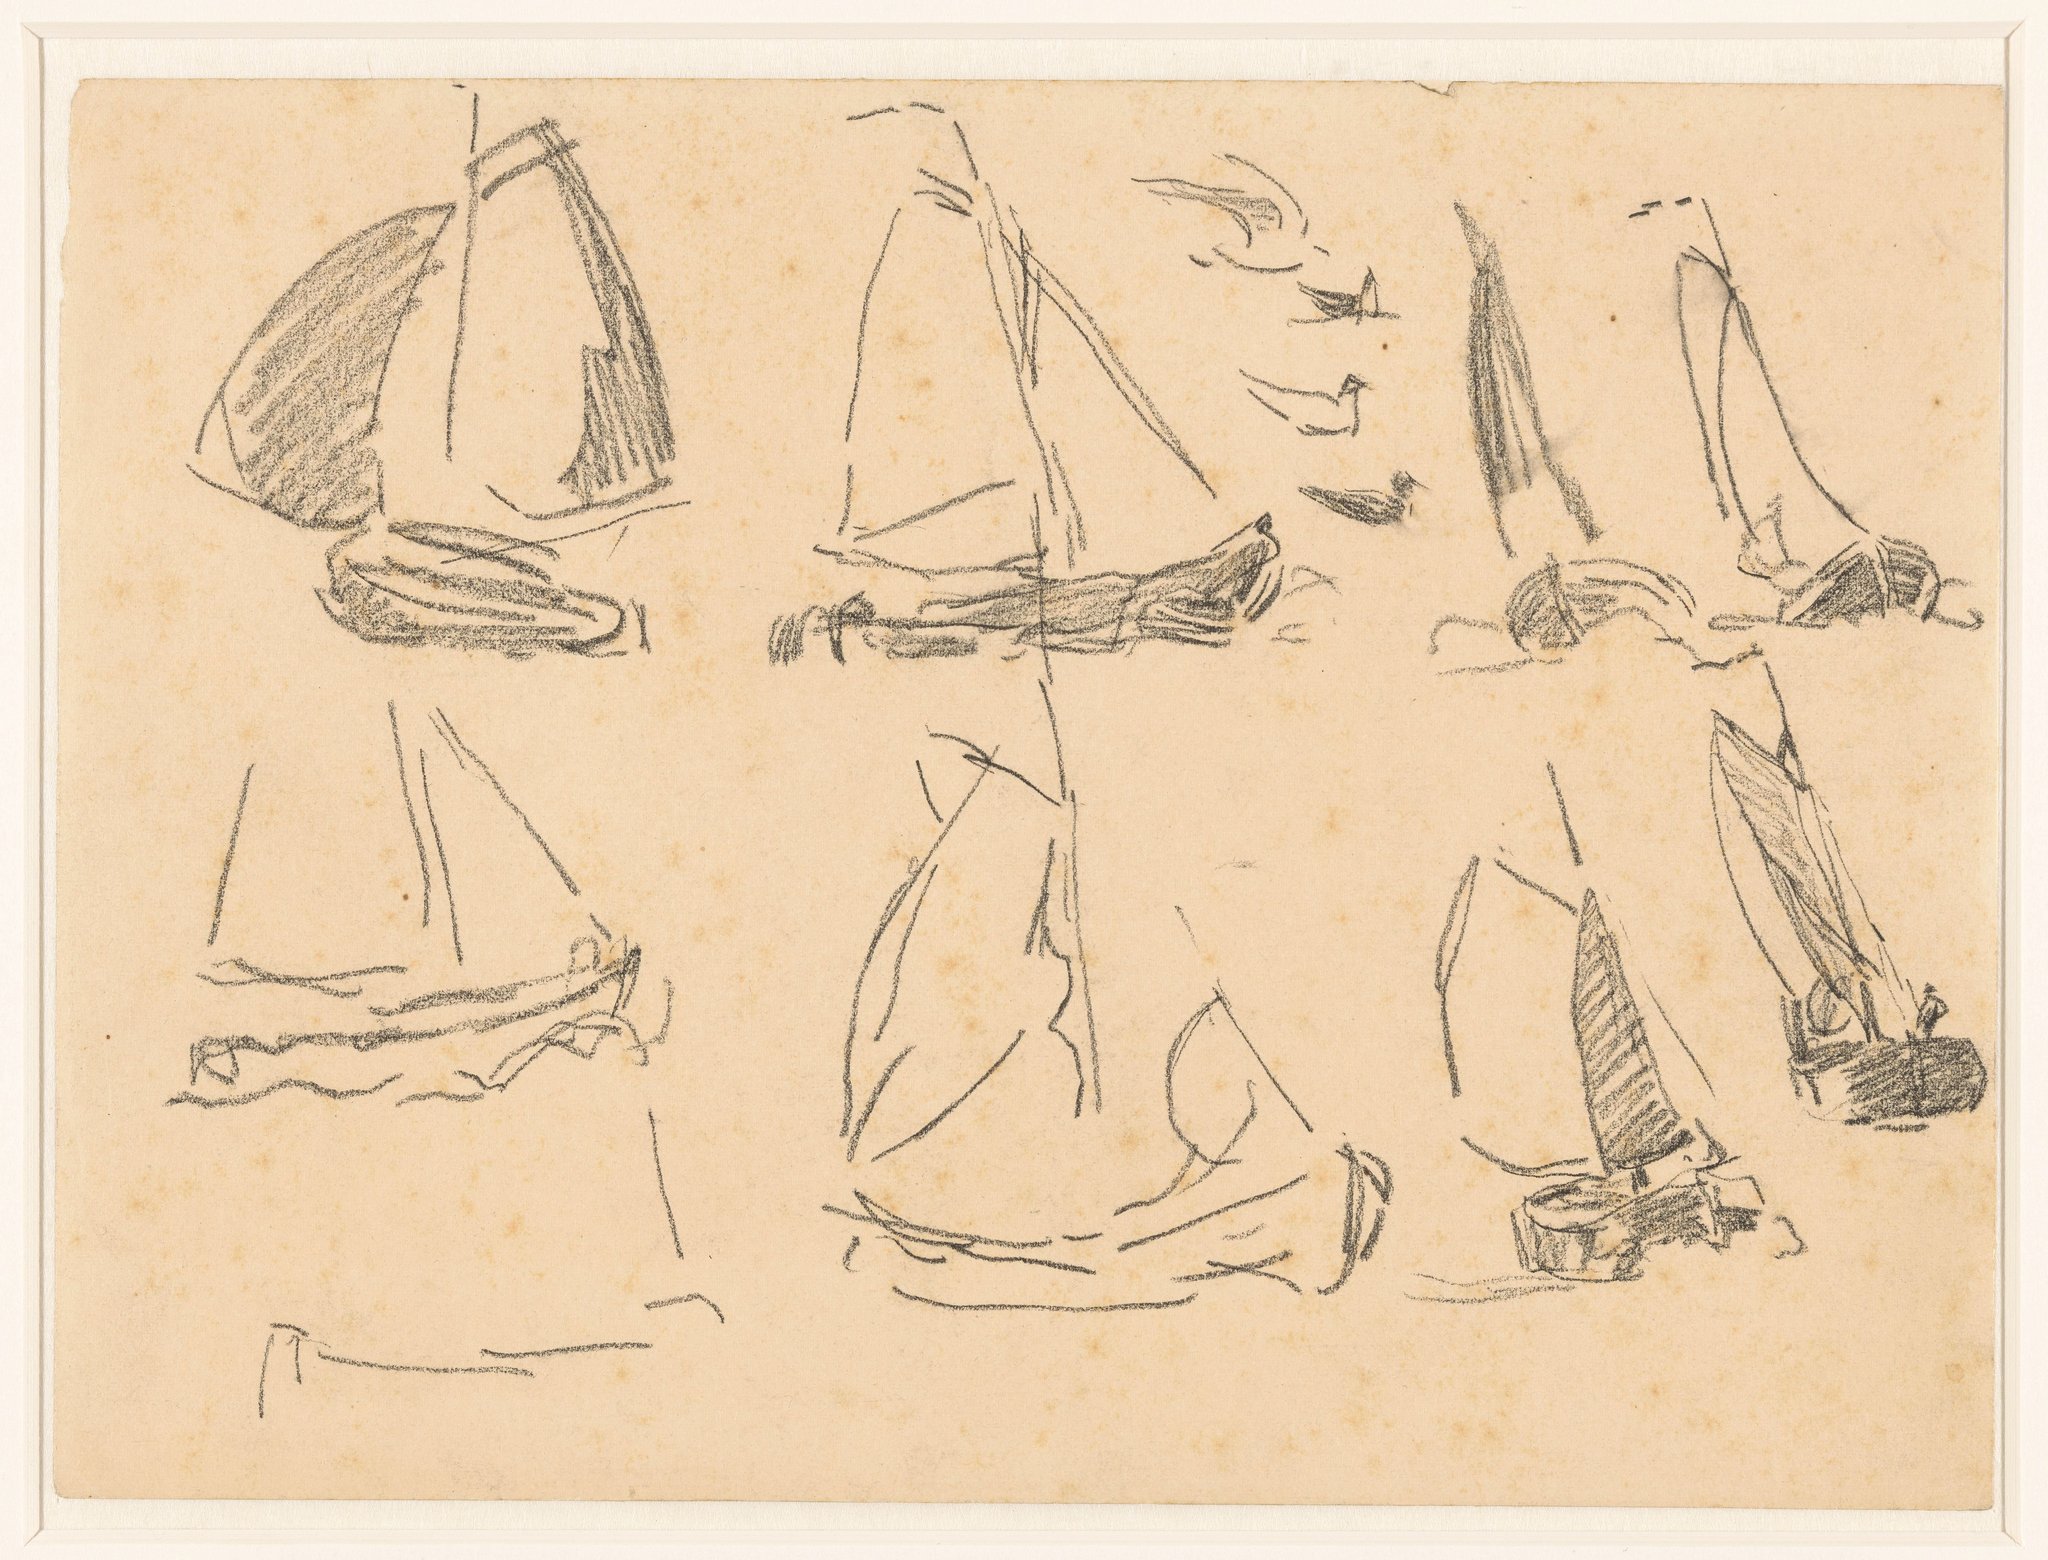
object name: drawing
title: Studieblad met diverse boten en meeuwen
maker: willem bastiaan tholen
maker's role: draughtsman, painter, print maker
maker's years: 1860-1931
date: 1870-1931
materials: chalk, paper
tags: ships (in general) - cc - more than one ship